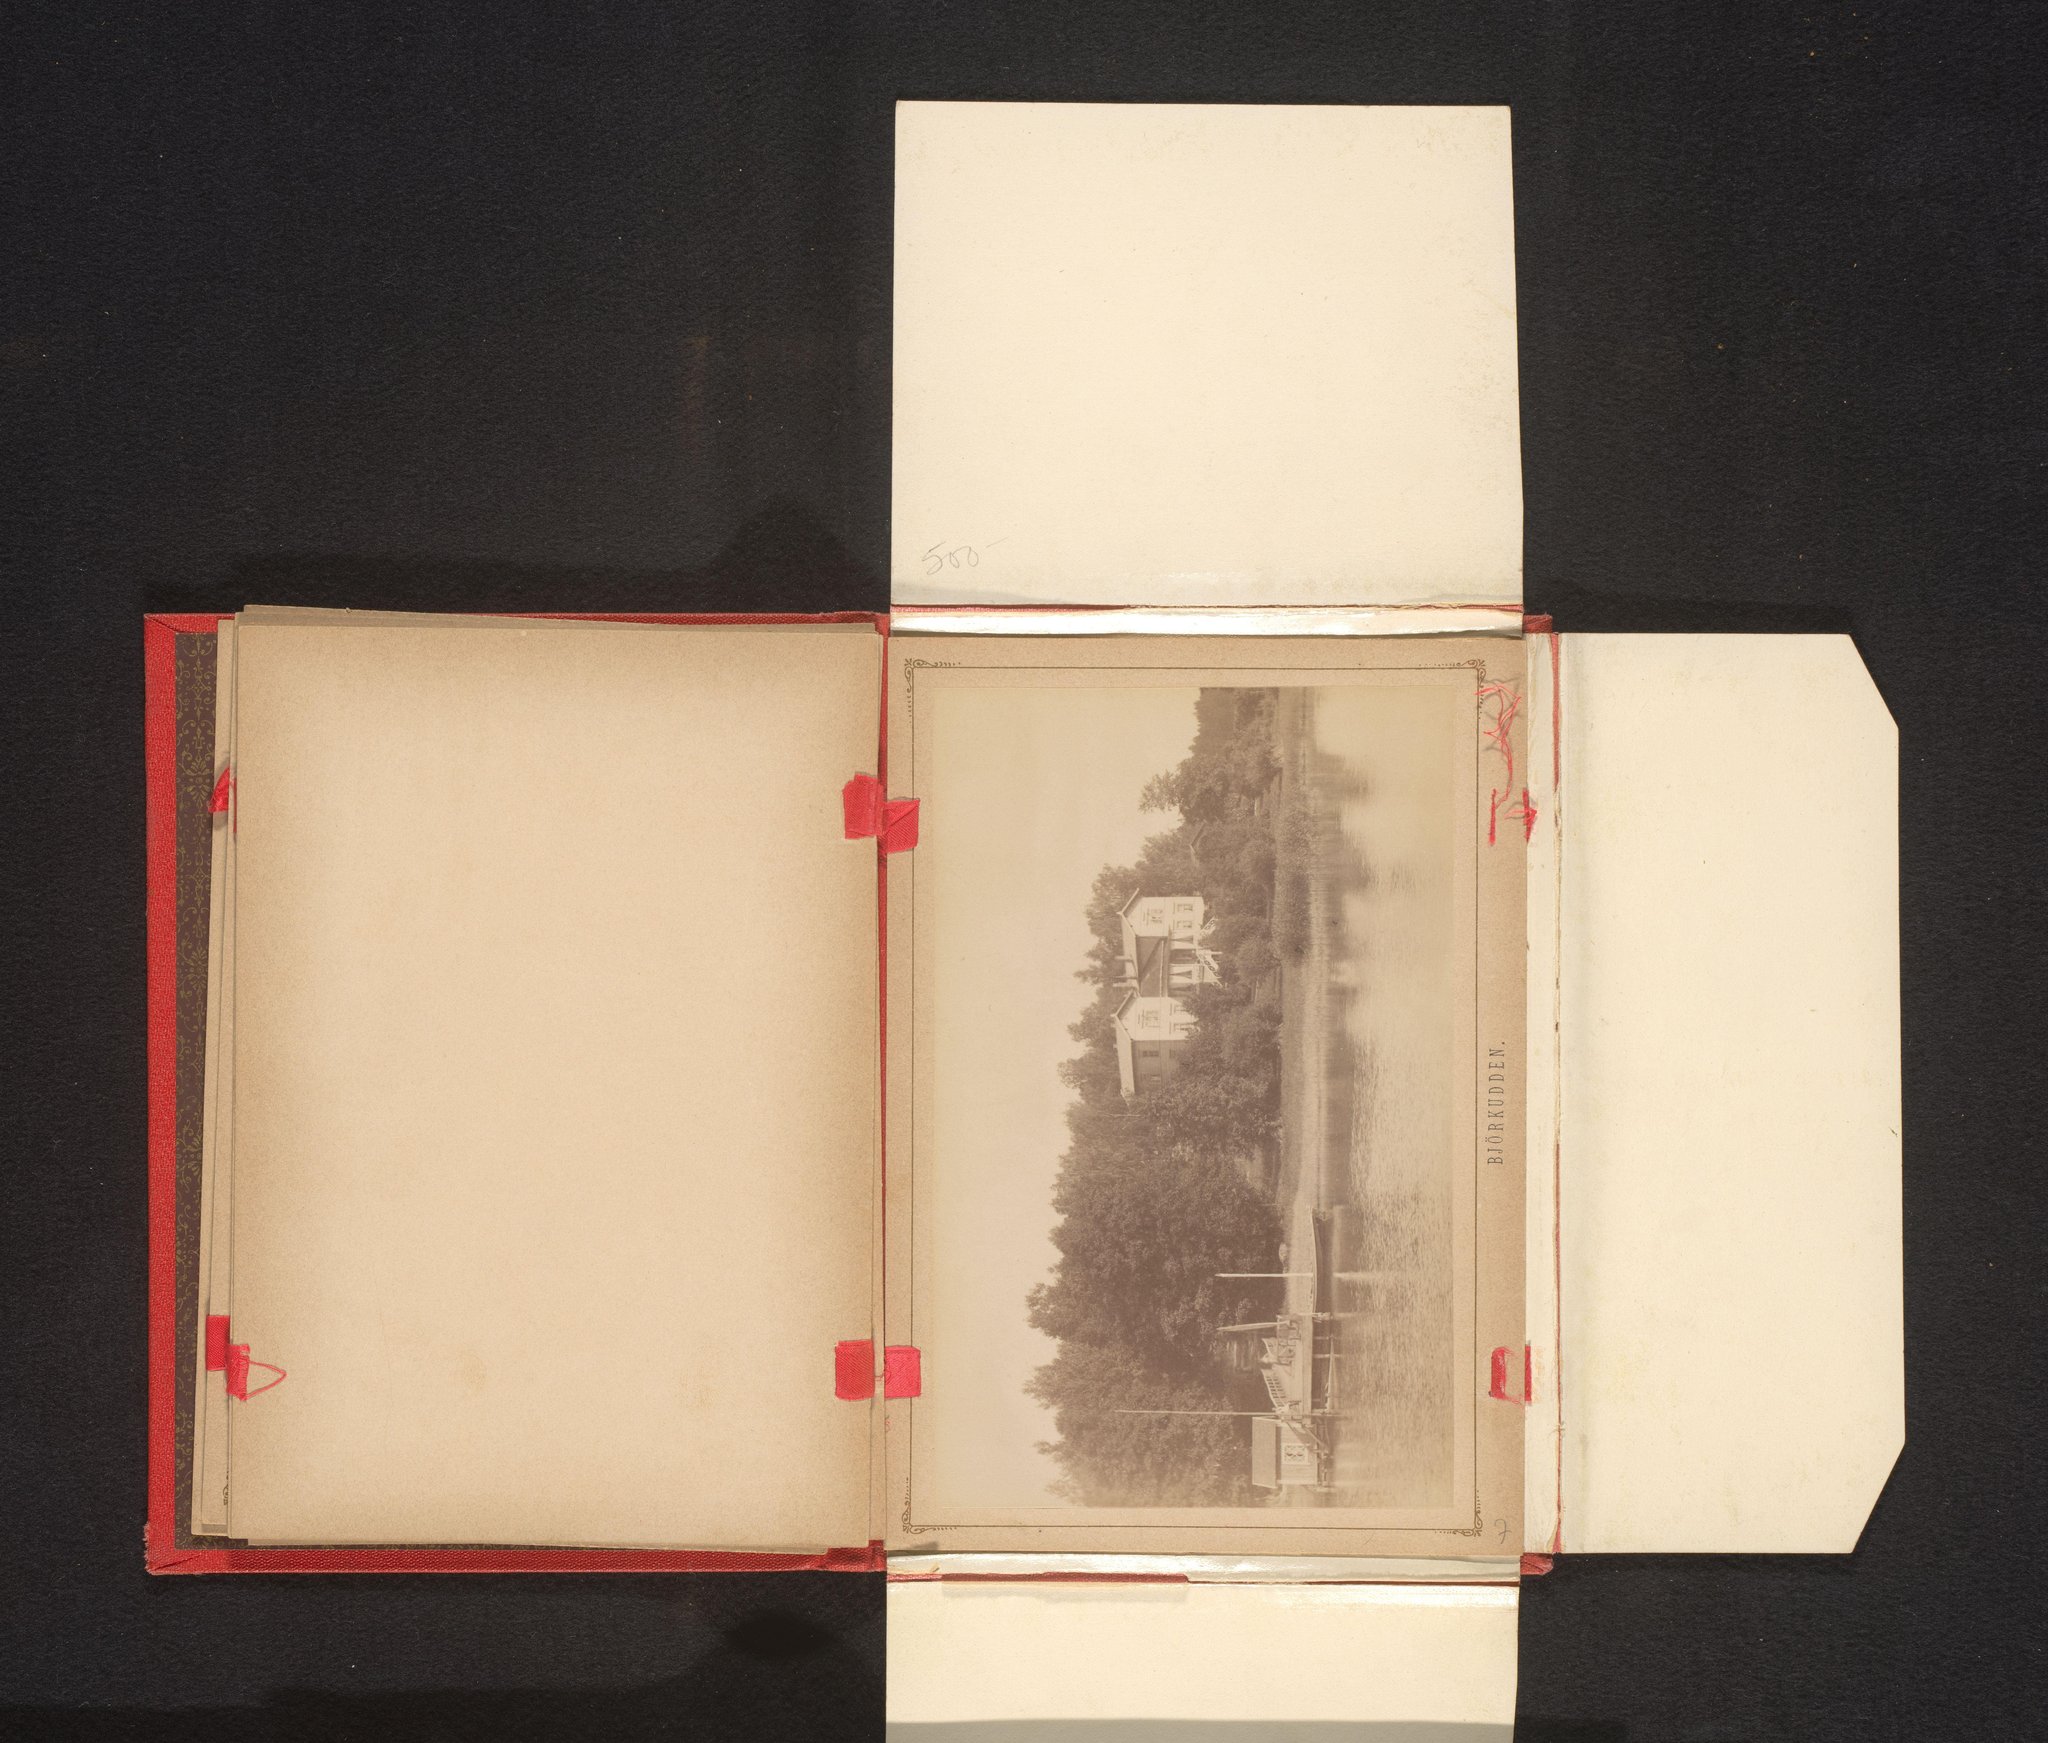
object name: page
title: Björkudden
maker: daniel nyblin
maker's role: fotograaf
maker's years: 1856-1923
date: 1879-1884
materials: photographic support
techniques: albumen print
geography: helsinki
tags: rural housing, e.g. country-house, villa, cottage, façade (of house or building)